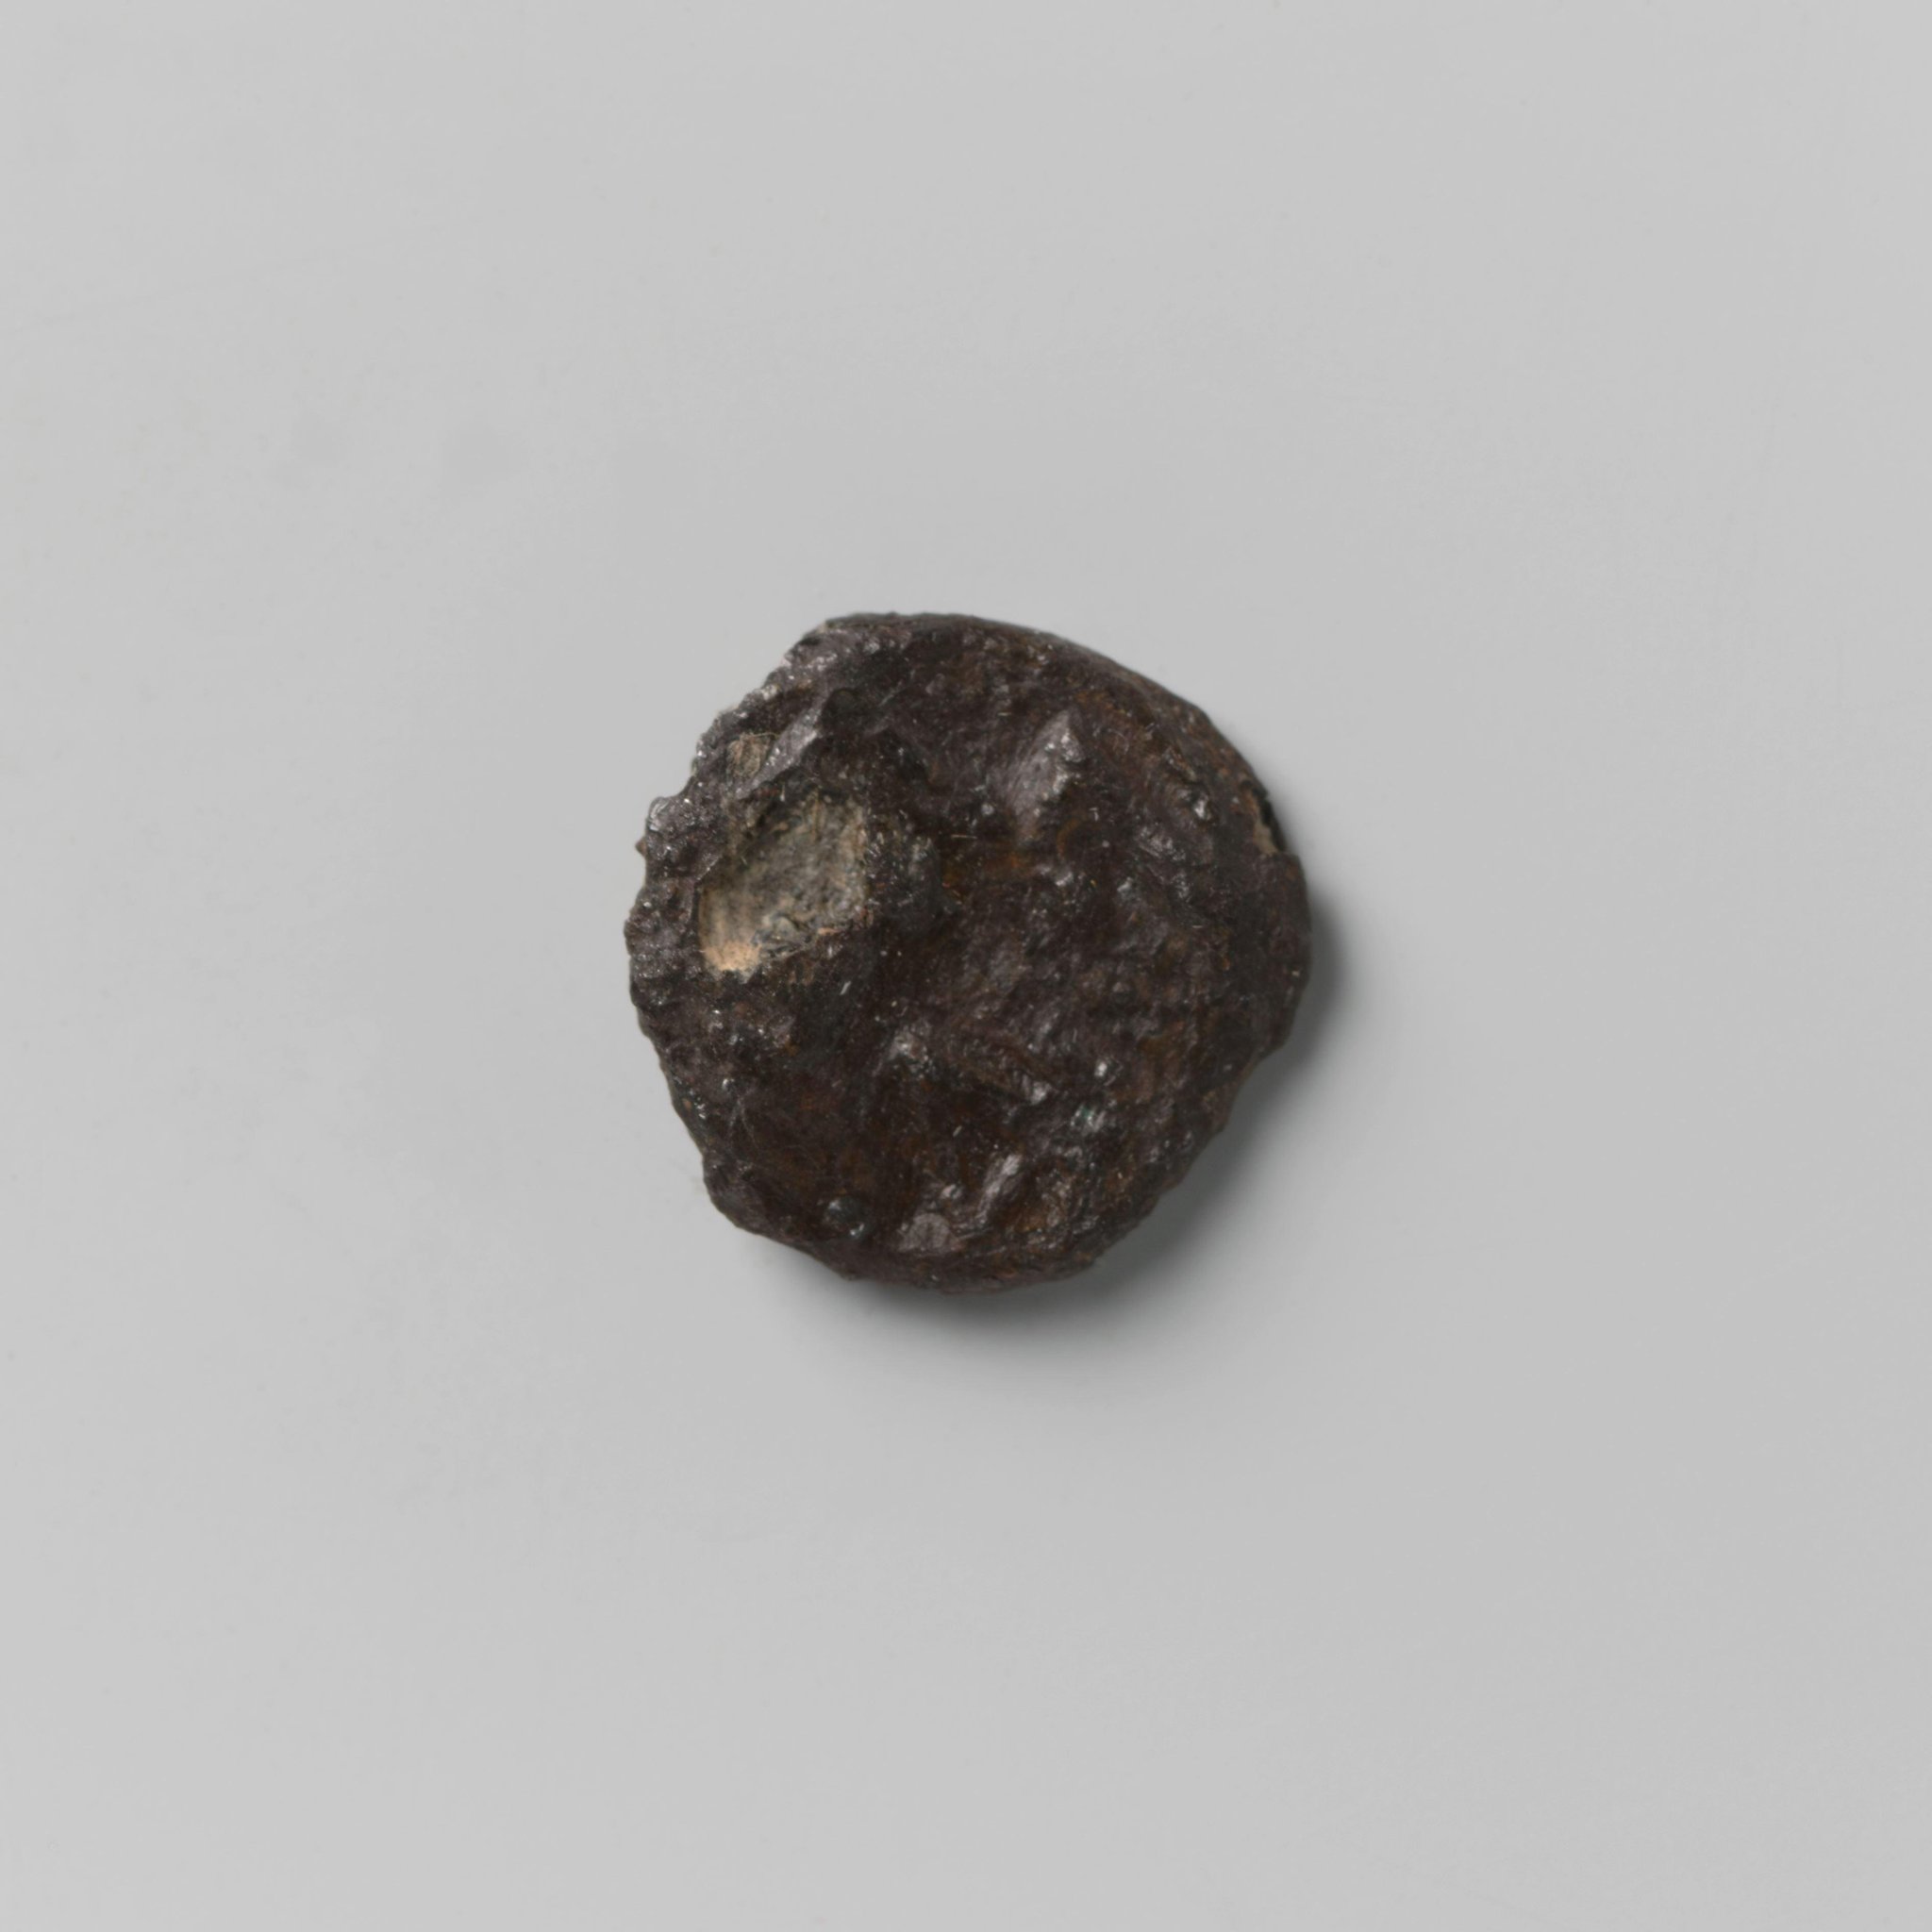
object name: coin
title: VOC, Ceylon, bazaroek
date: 1747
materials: tin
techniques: casting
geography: colombo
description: Tinnen munt. Voorzijde: in twee regels jaartal, in het midden ronde uitholling. Keerzijde: in twee regels vier Singalese lettertekens.